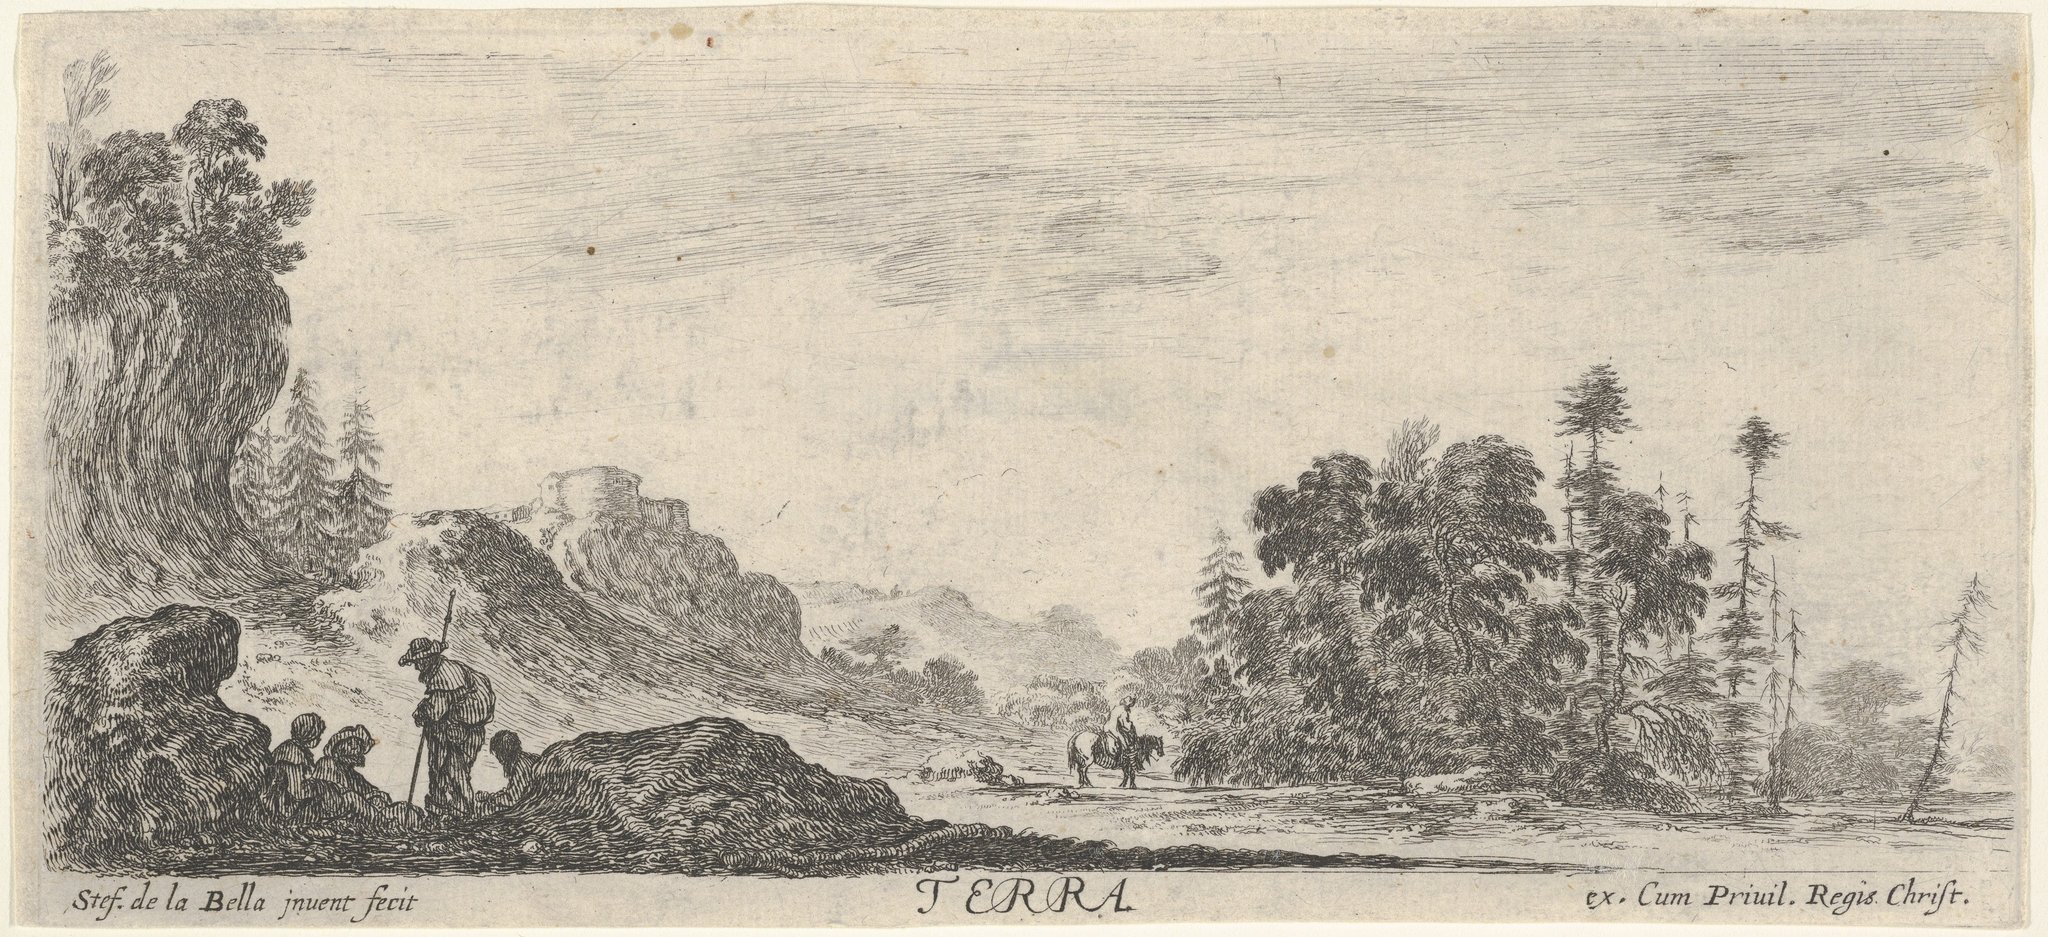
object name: print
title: Earth, four figures in foreground to left, hills to left in the background, many trees to right in the background, a horseman in center in the background, from "The Four Elements" (Les Quatre Eléments)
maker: stefano della bella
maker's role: artist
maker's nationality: italian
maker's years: 1610-1664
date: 1645-1650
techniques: etching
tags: men,horses,hills,trees